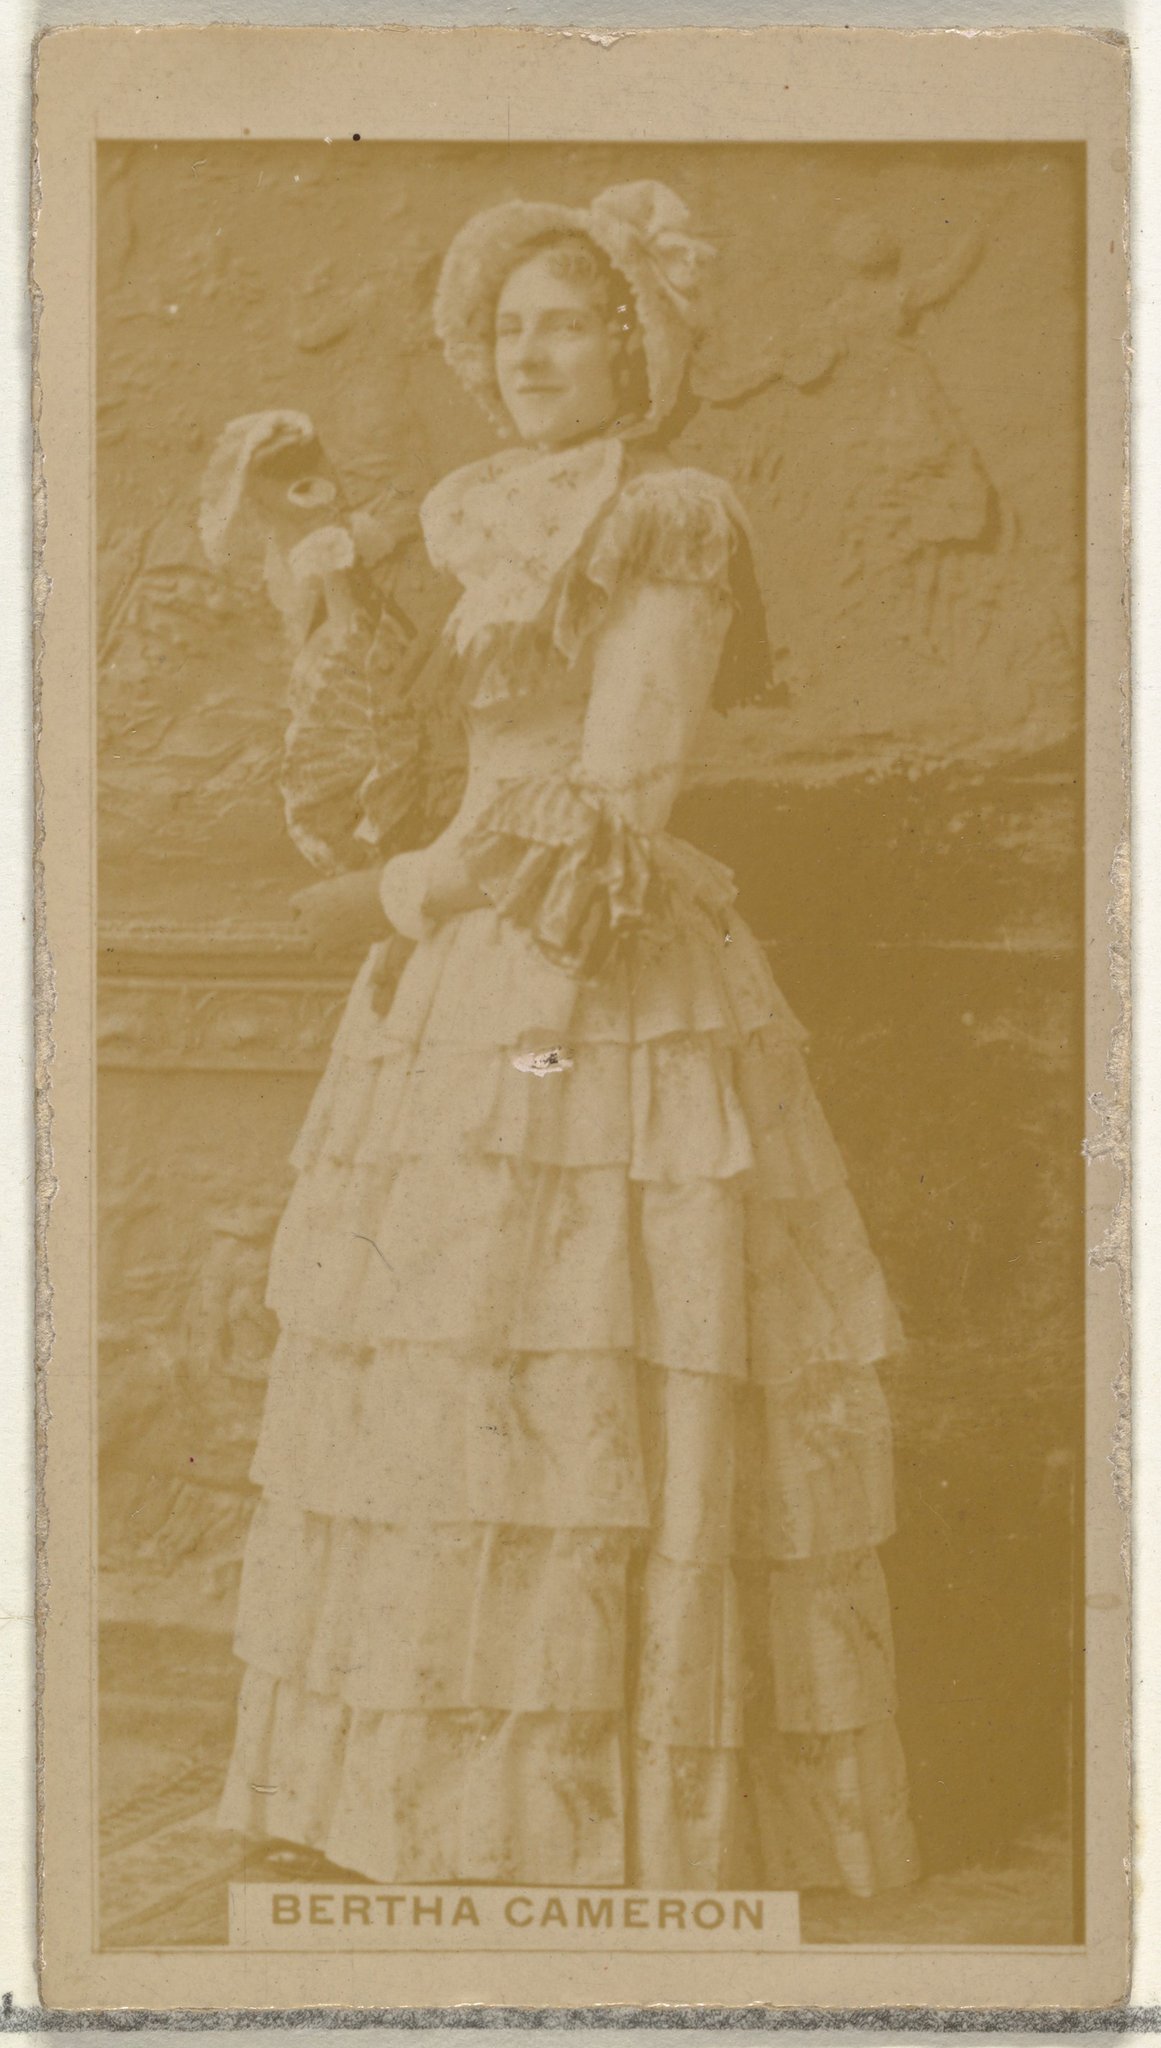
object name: photograph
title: Bertha Cameron, from the Actors and Actresses series (N145-8) issued by Duke Sons & Co. to promote Duke Cigarettes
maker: w. duke, sons & co.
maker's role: publisher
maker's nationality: american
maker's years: 1870-1920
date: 1891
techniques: albumen silver print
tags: portraits,women,actresses